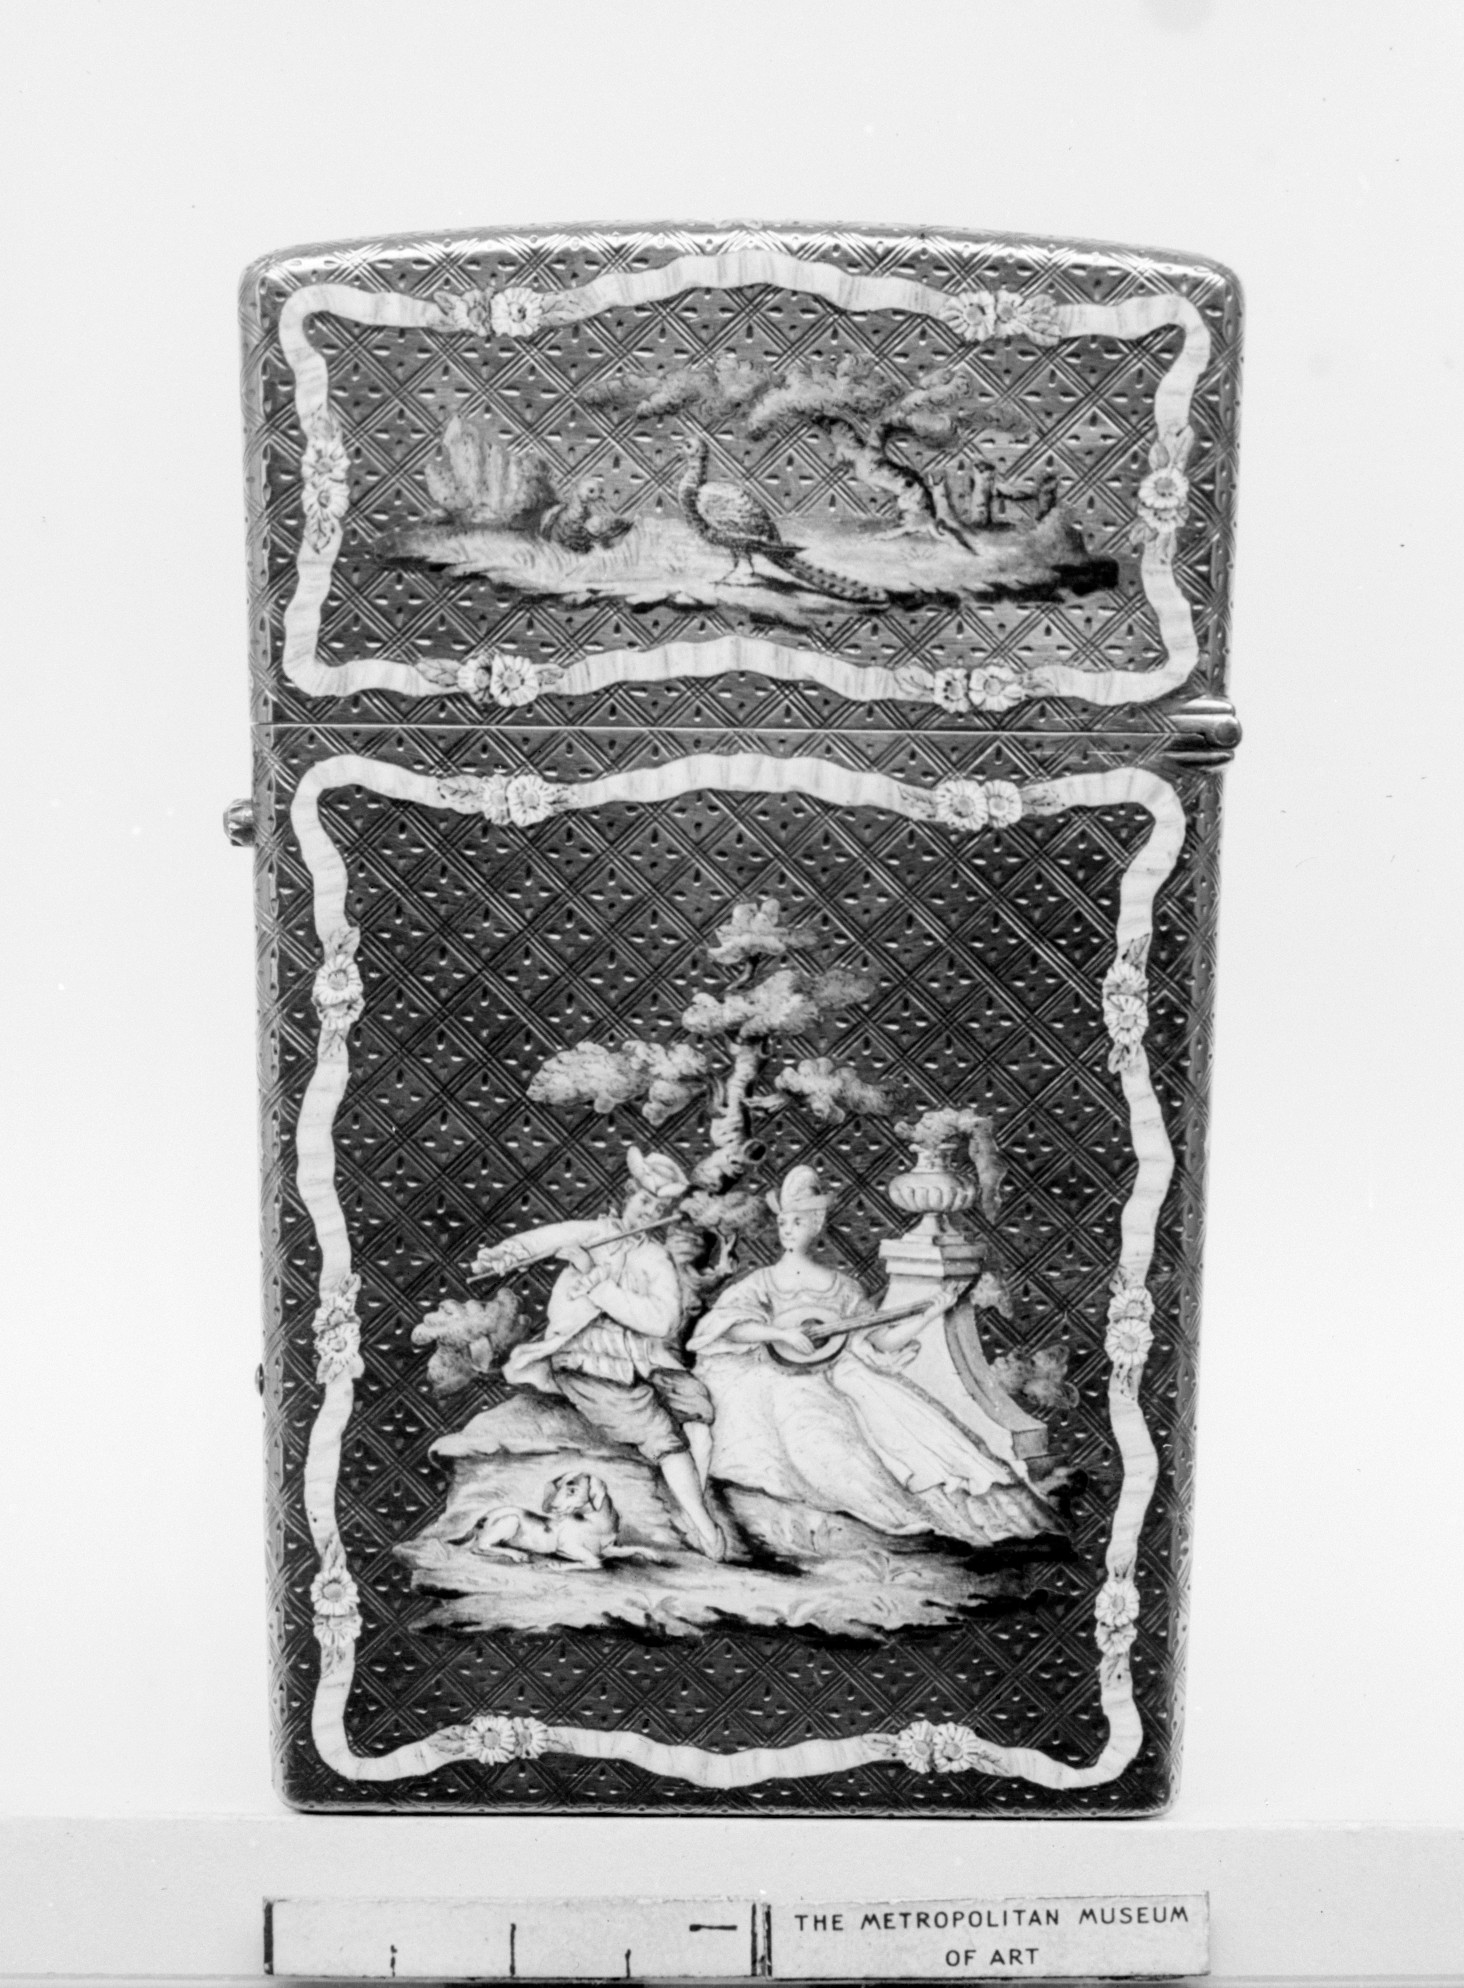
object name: souvenir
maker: jean-baptiste bertin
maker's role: maker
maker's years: 1671-1771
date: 1765-1766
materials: diamond, enamel, gold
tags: musical instruments,men,women,peacocks,trees